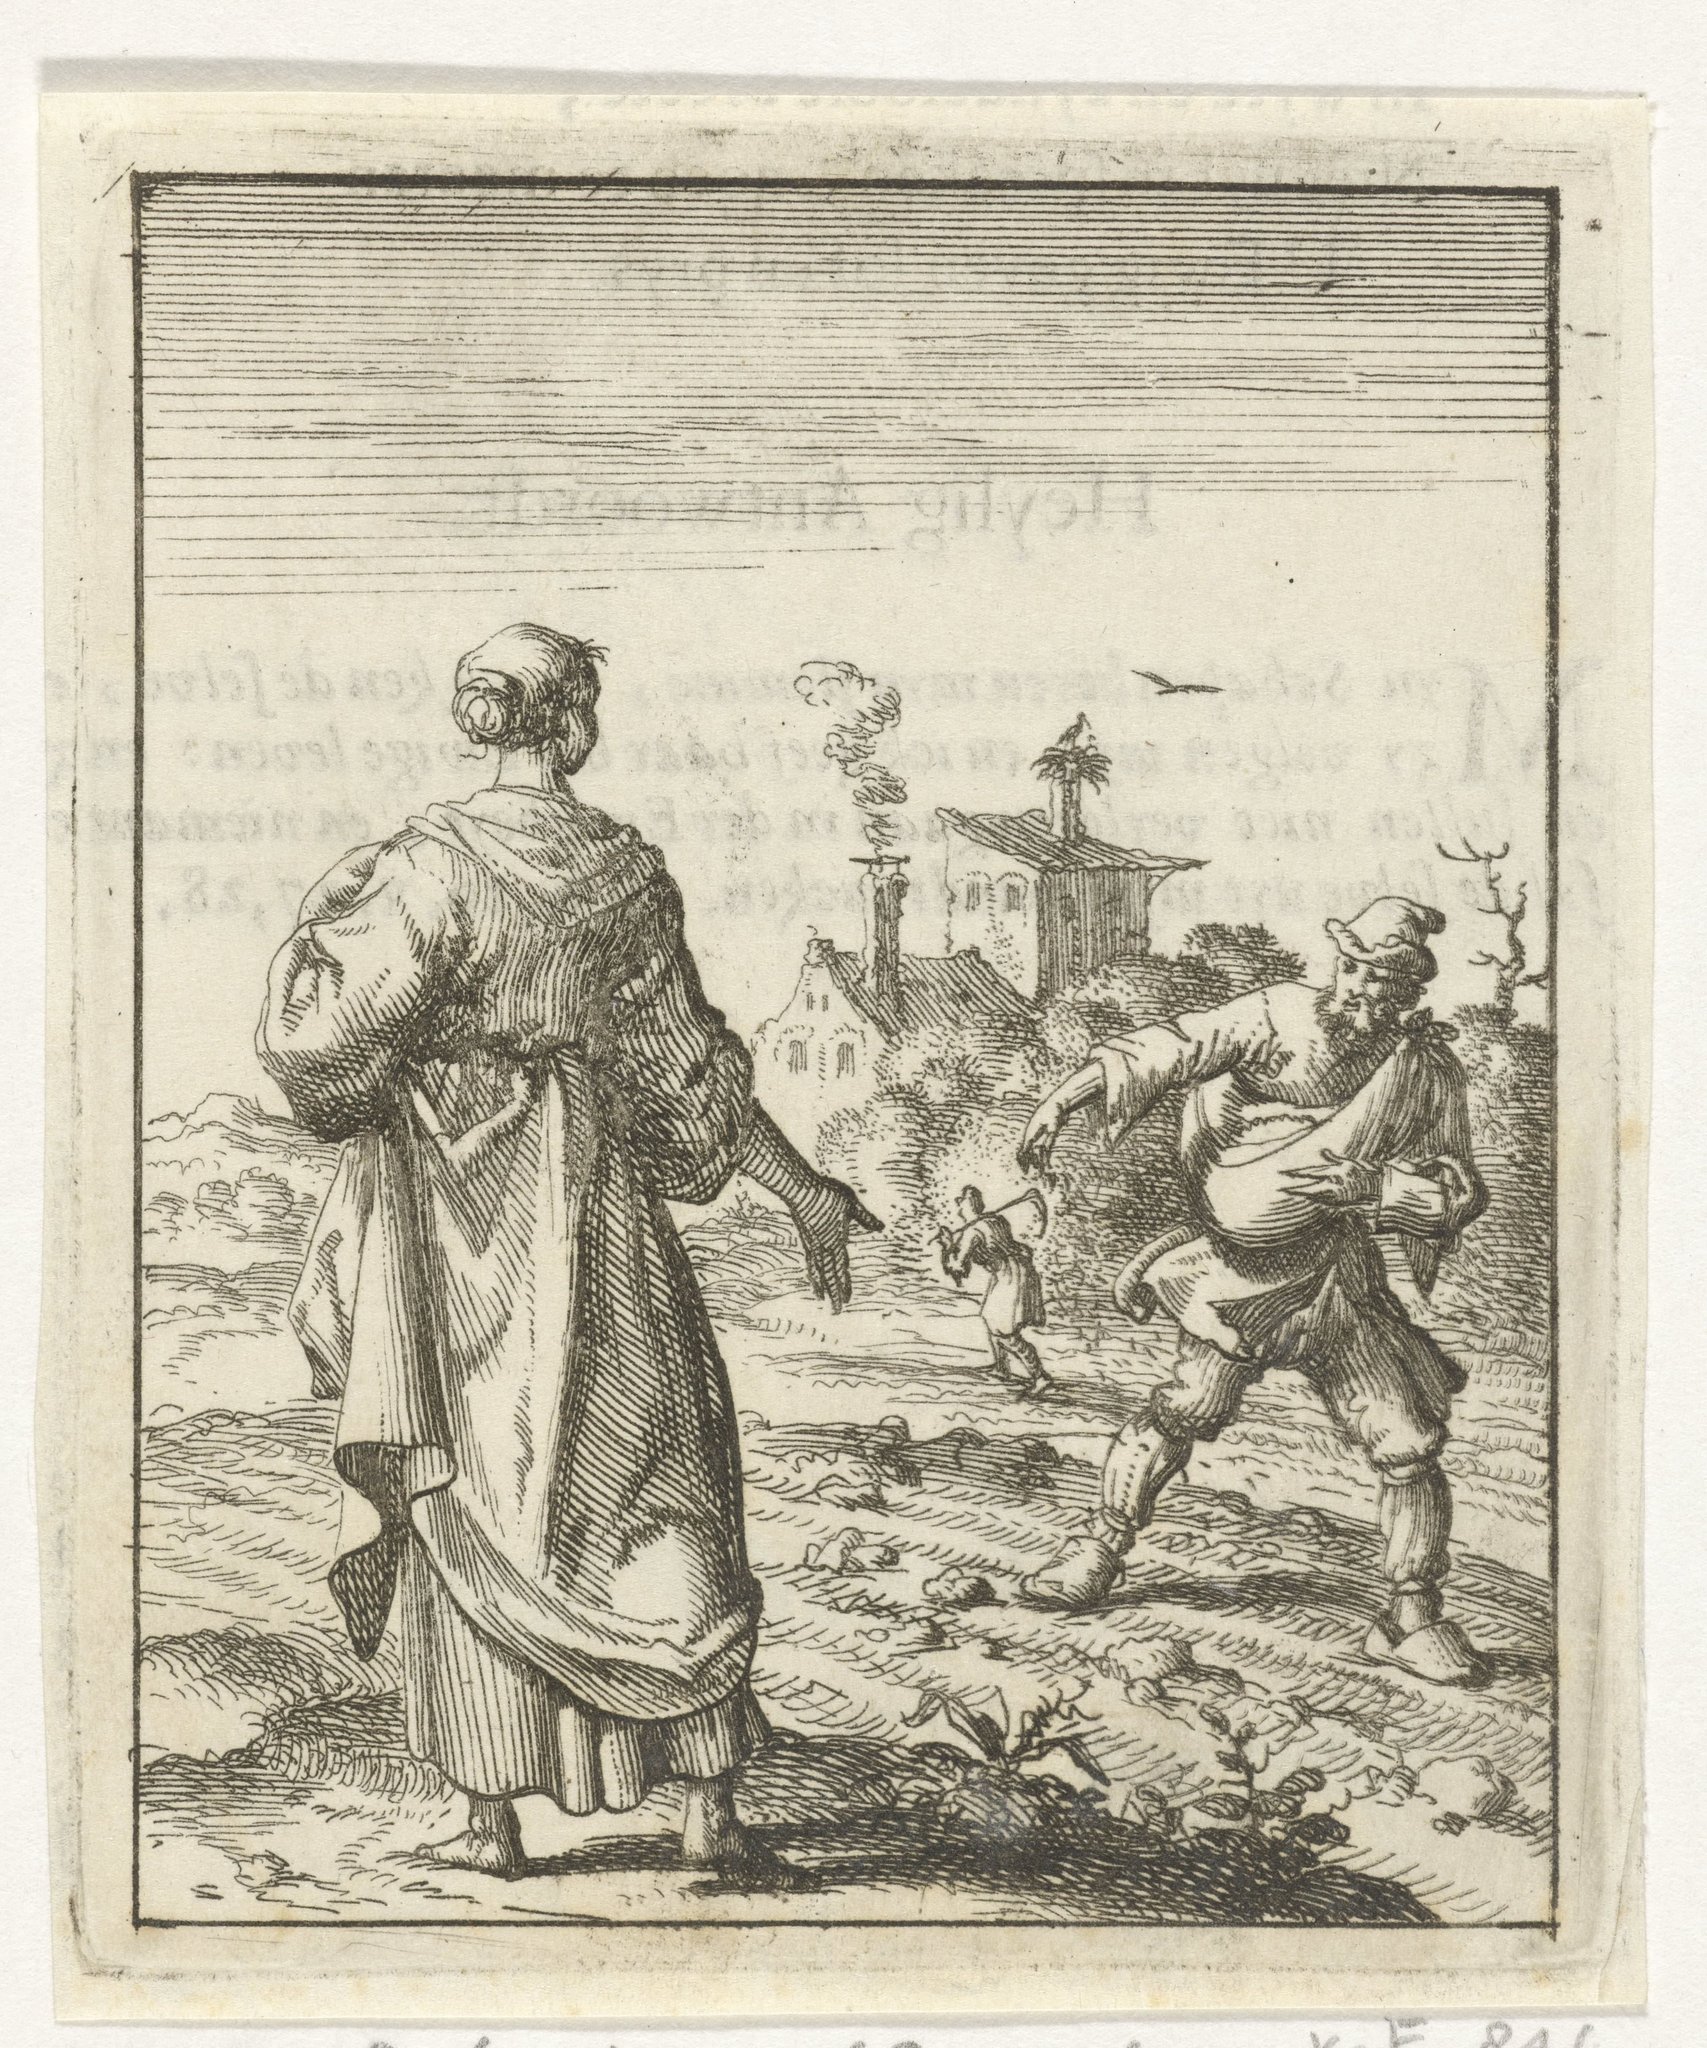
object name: book illustration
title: Die Godt vertrout, Heeft wel gebout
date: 1687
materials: paper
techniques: etching, letterpress printing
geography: amsterdam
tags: sowing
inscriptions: collector's mark: Lugt 2228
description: Illustratie uit: Luyken, Jan. Voncken der liefde Jesu, van het godtbegerende zielenvier. Amsterdam: Pieter Arentsz (II), 1687, p. 42.